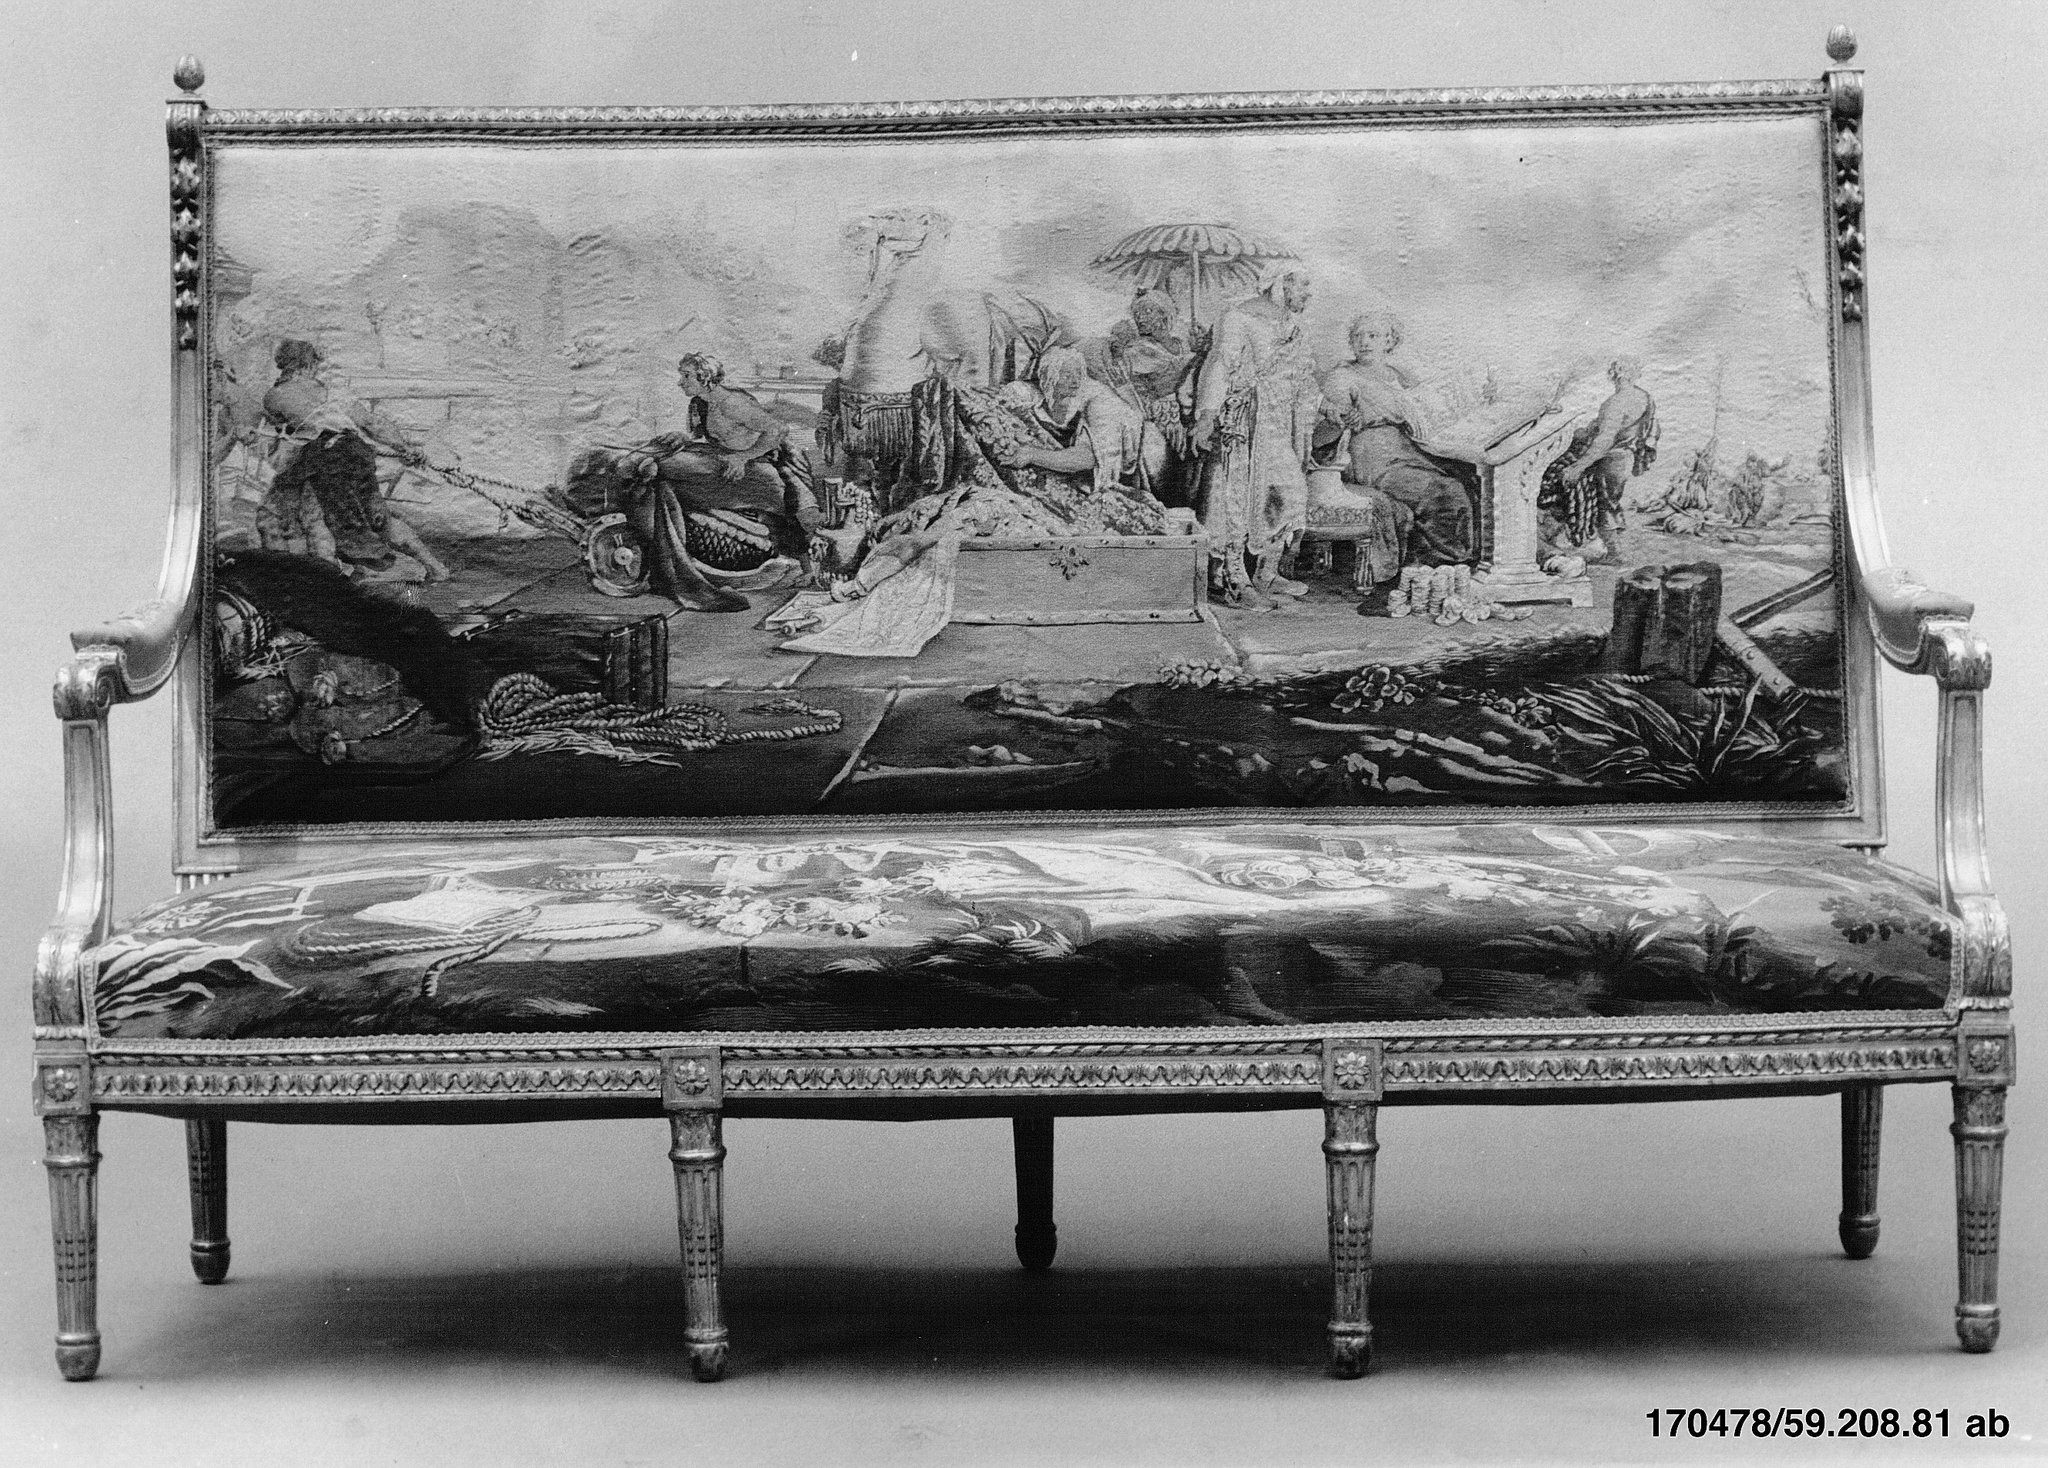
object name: upholstery panel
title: Two upholstery panels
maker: jean jacques lagrenée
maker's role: designer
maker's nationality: french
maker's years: 1739-1821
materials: silk, wool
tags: men,women